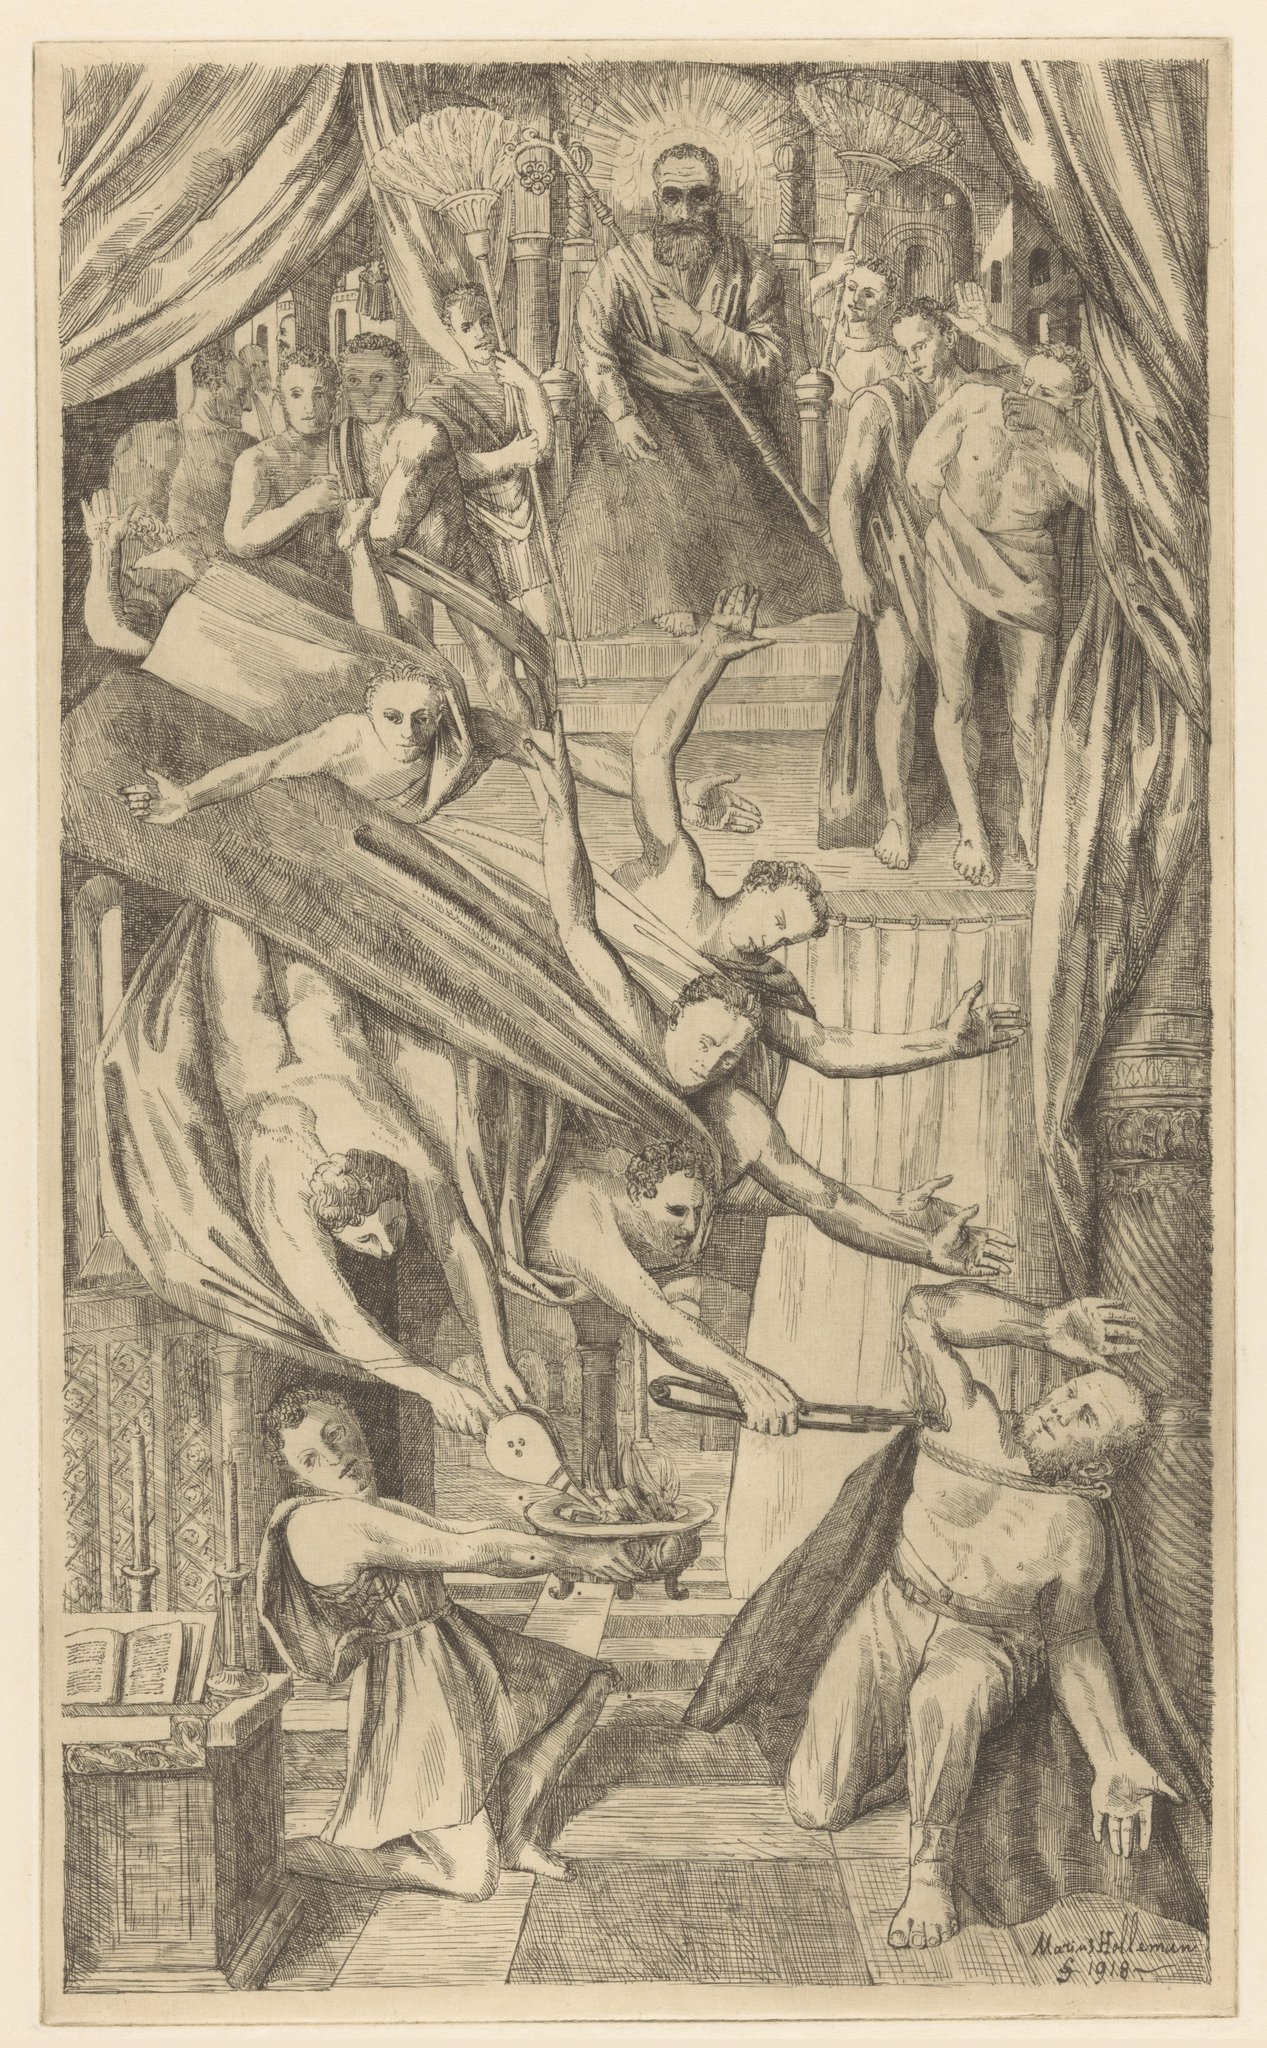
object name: print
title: Lippen van Jesaja met gloeiende kool gereinigd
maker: marius holleman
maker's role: draughtsman, print maker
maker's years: 1878-1926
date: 1918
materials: paper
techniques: etching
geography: groningen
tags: purification of isaiah: an angel touches isaiah's lips with a burning coal, taken from the altar with tongs ~ isaiah's visions (isaiah 6:5-13)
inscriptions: collector's mark: Lugt 2228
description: God verschijnt op een troon aan Jesaja. Een engel vliegt naar Jesaja en reinigt zijn lippen met een tang met een gloeiende kool. Een andere engel wakkert met een blaasbalg het vuur aan.